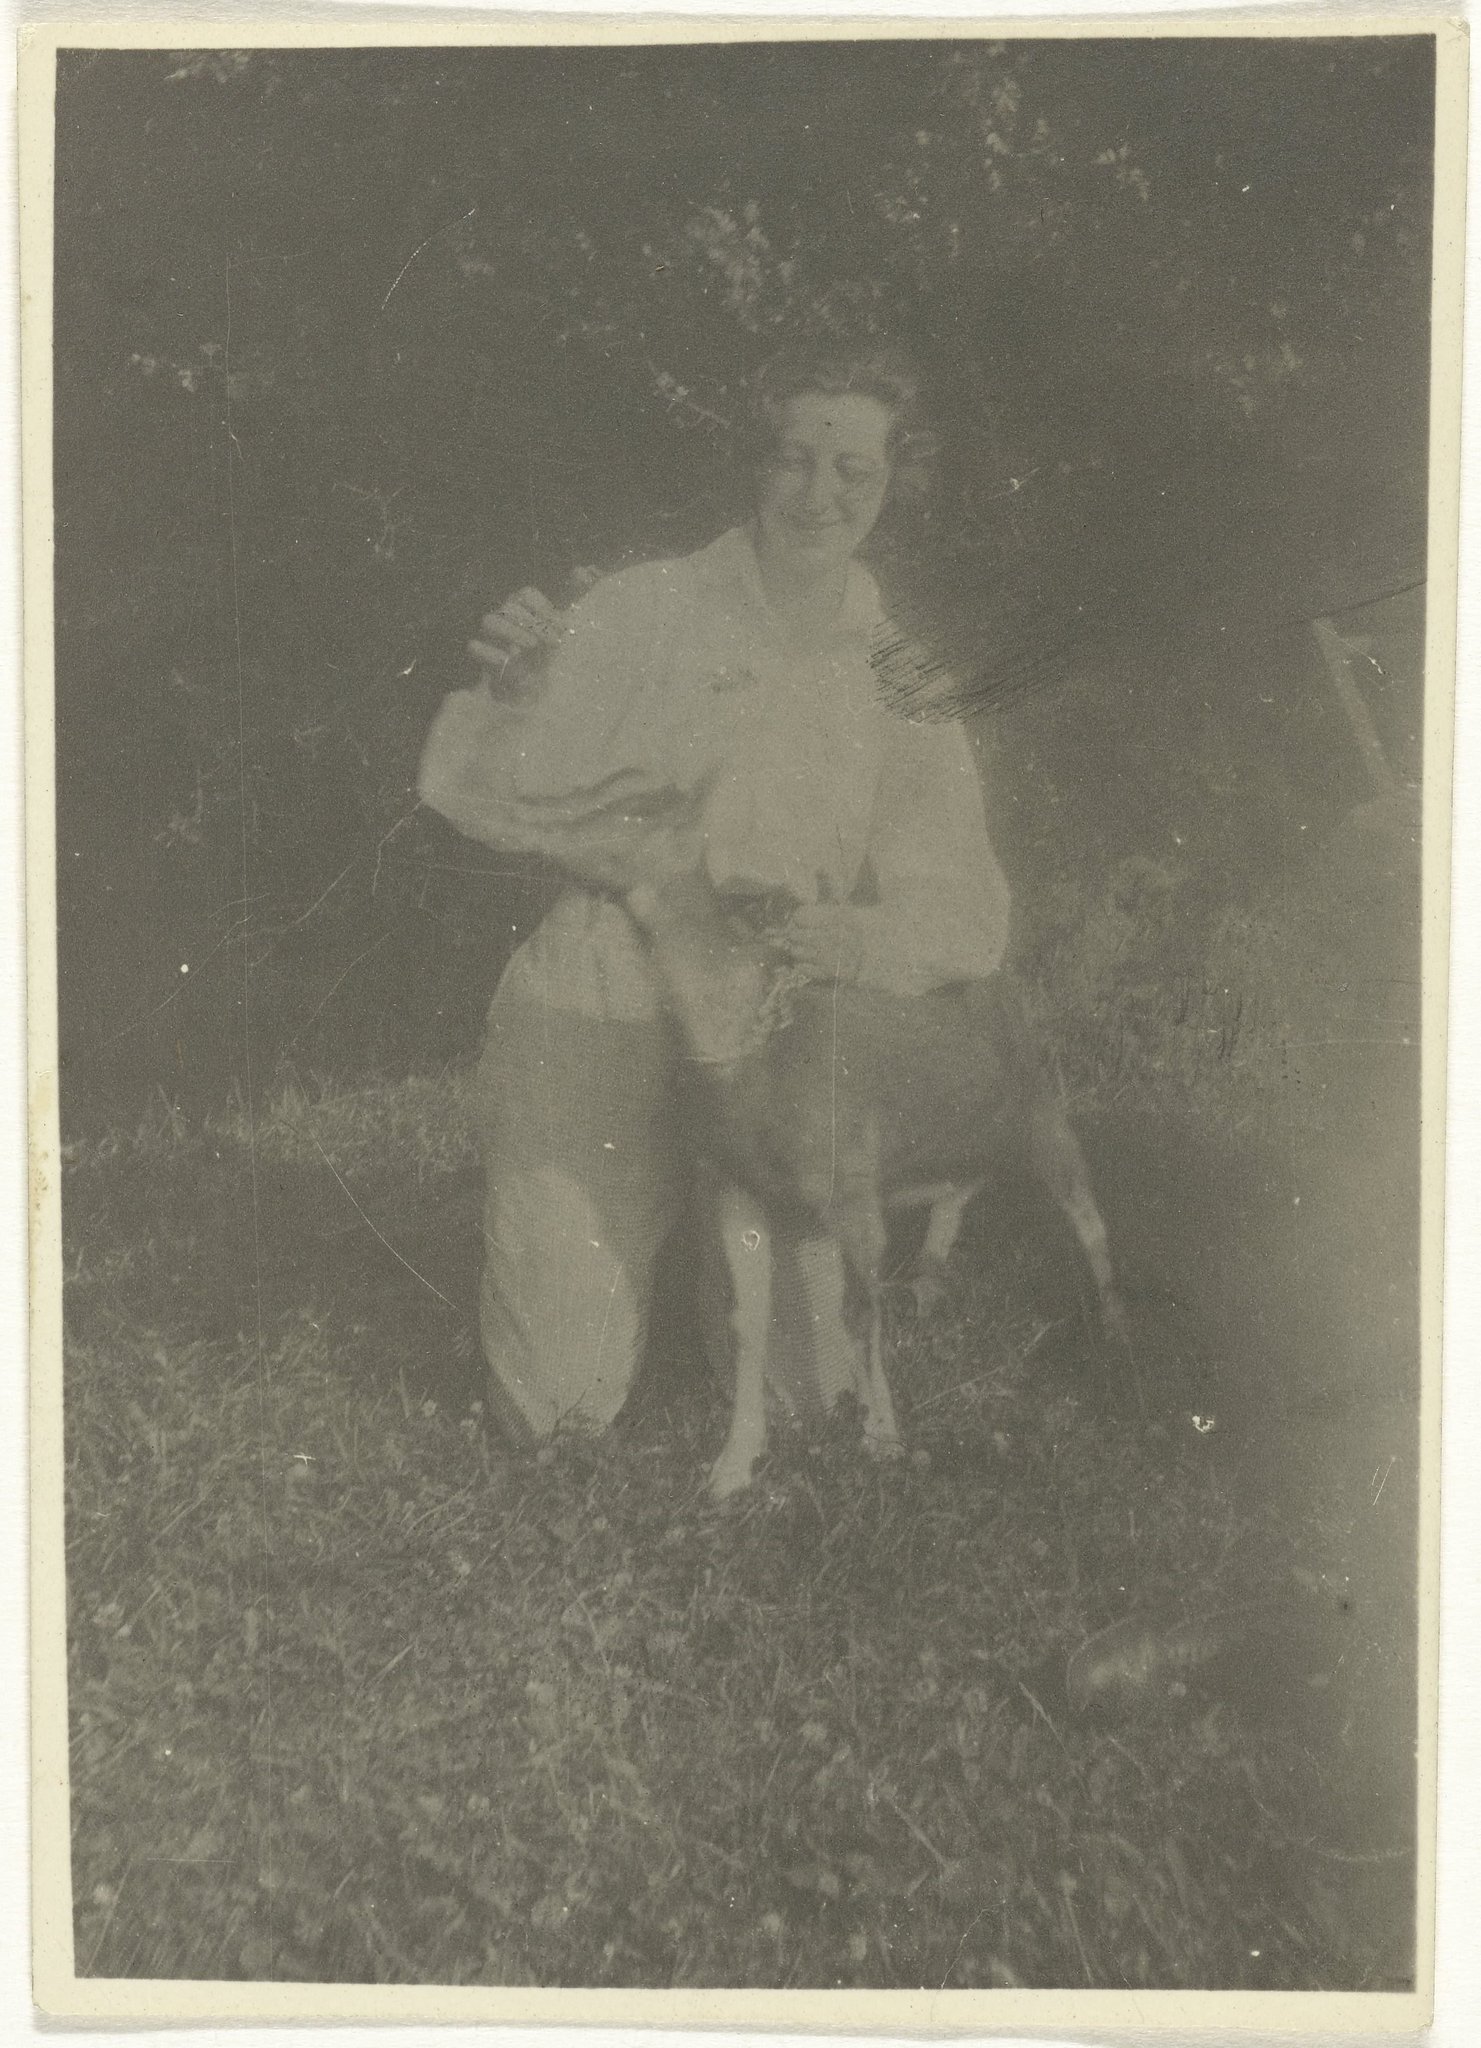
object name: photograph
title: Portret van Irene With met geit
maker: Anonymous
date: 1920-1935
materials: paper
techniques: gelatin silver print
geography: germany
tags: adult woman, historical persons, goat, germany